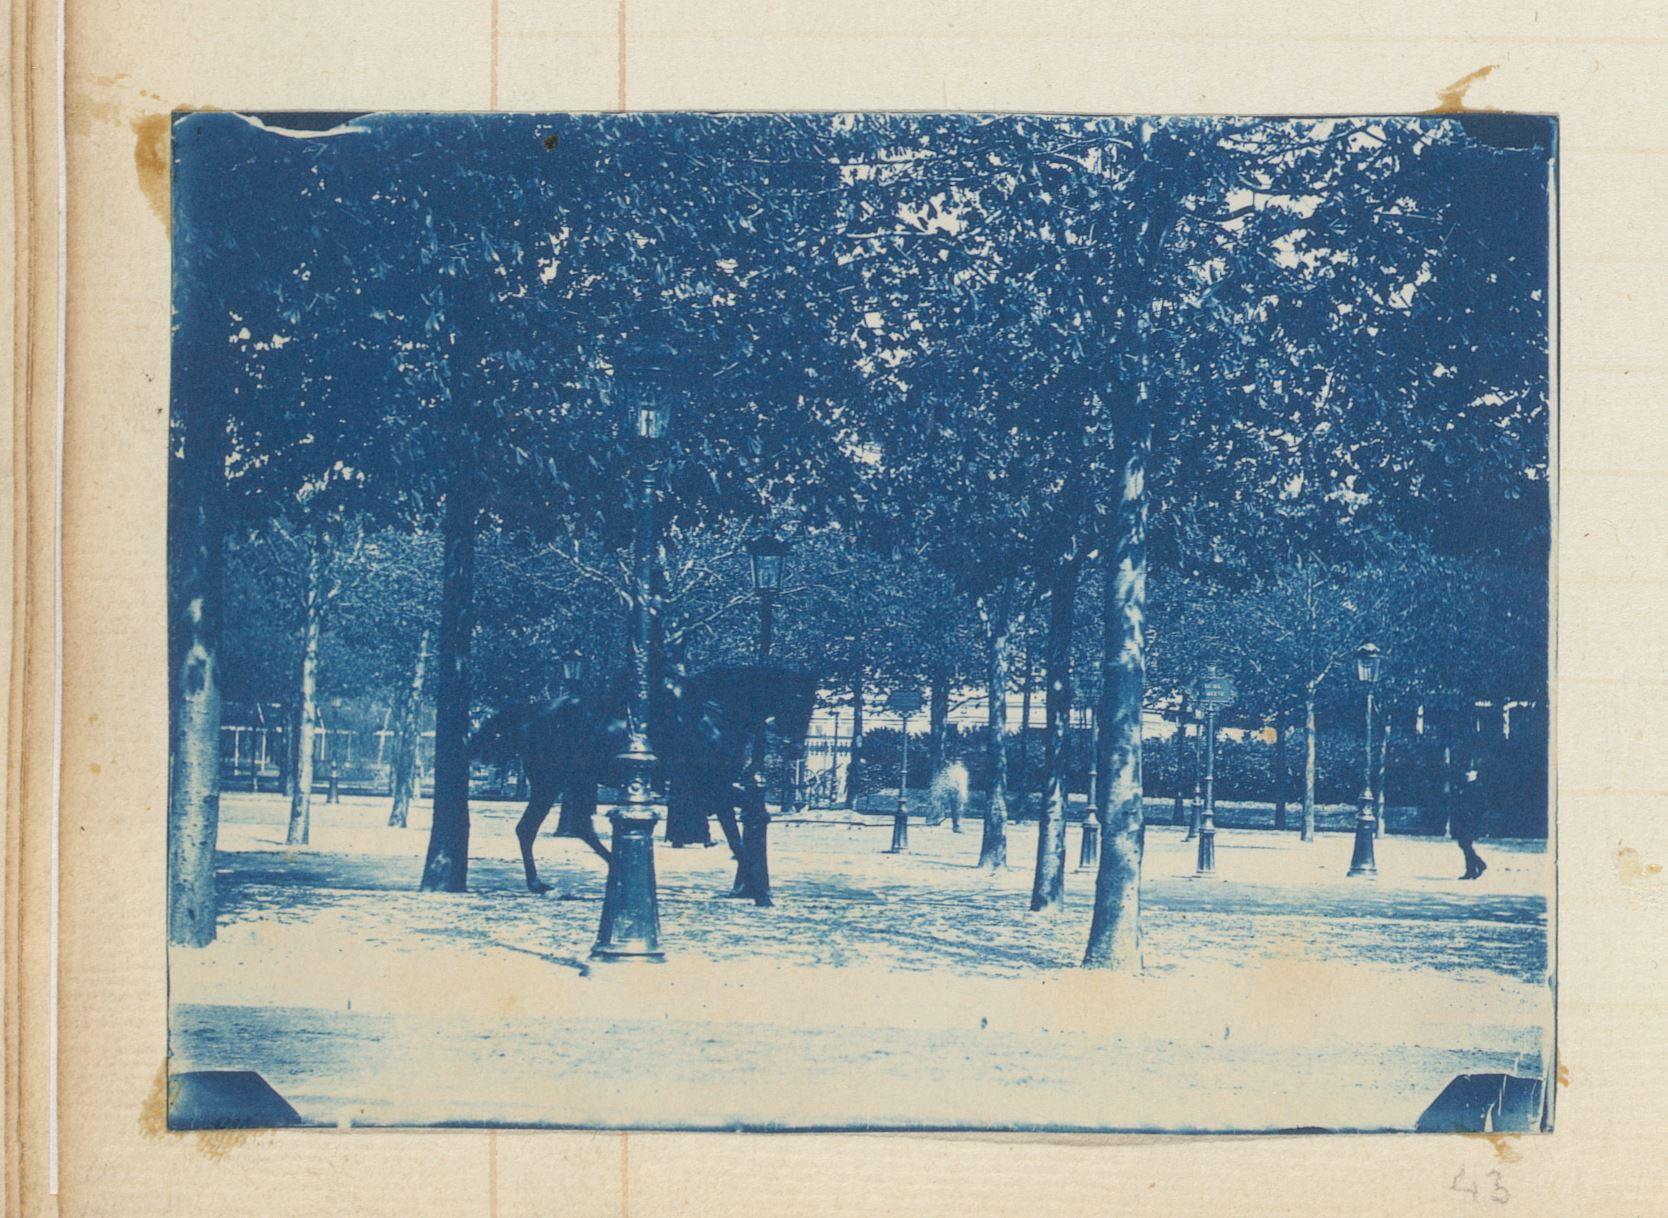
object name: photograph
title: Ruiter in een park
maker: Anonymous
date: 1880-1900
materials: paper, photographic support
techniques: cyanotype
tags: riding a horse, ass, or mule; rider, horseman